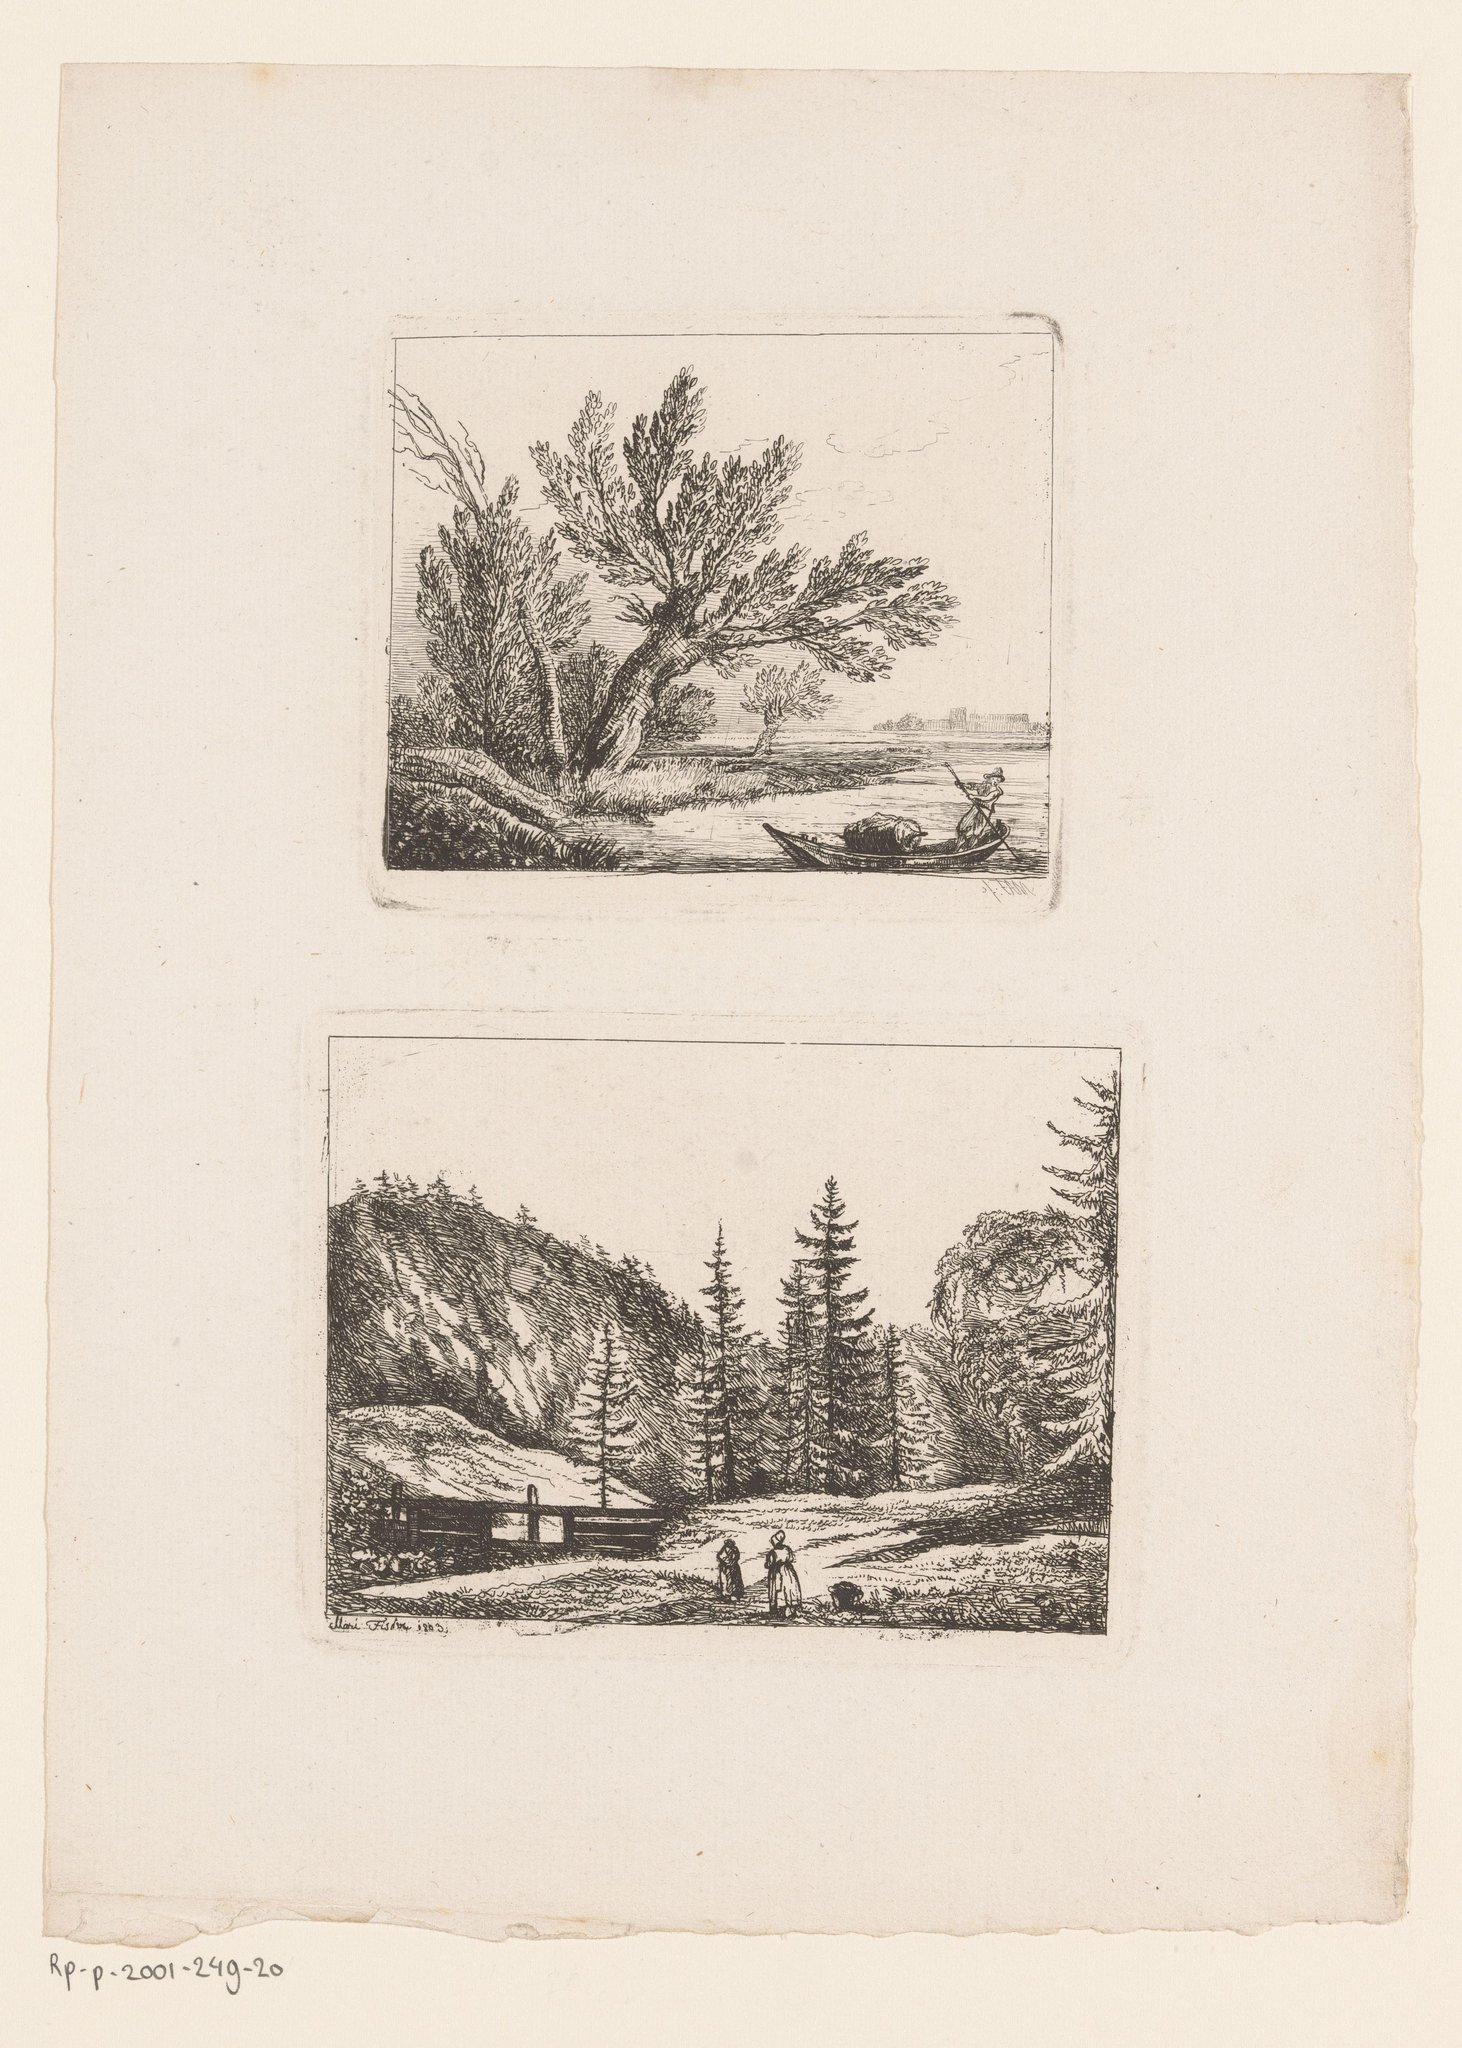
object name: print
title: Meine ersten Nadel Versuche: eine Folge von 28 Blättern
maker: marie anna fischer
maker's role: print maker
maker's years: 1782-1844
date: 1803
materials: paper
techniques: etching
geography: vienna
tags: river, trees: pine, boat propelled by man or animal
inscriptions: collector's mark: Lugt 2228, collector's mark: Lugt 2760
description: Boven een rivierlandschap met een man in een punter. Onder een landschap met dennenbomen en twee vrouwen bij een hek.